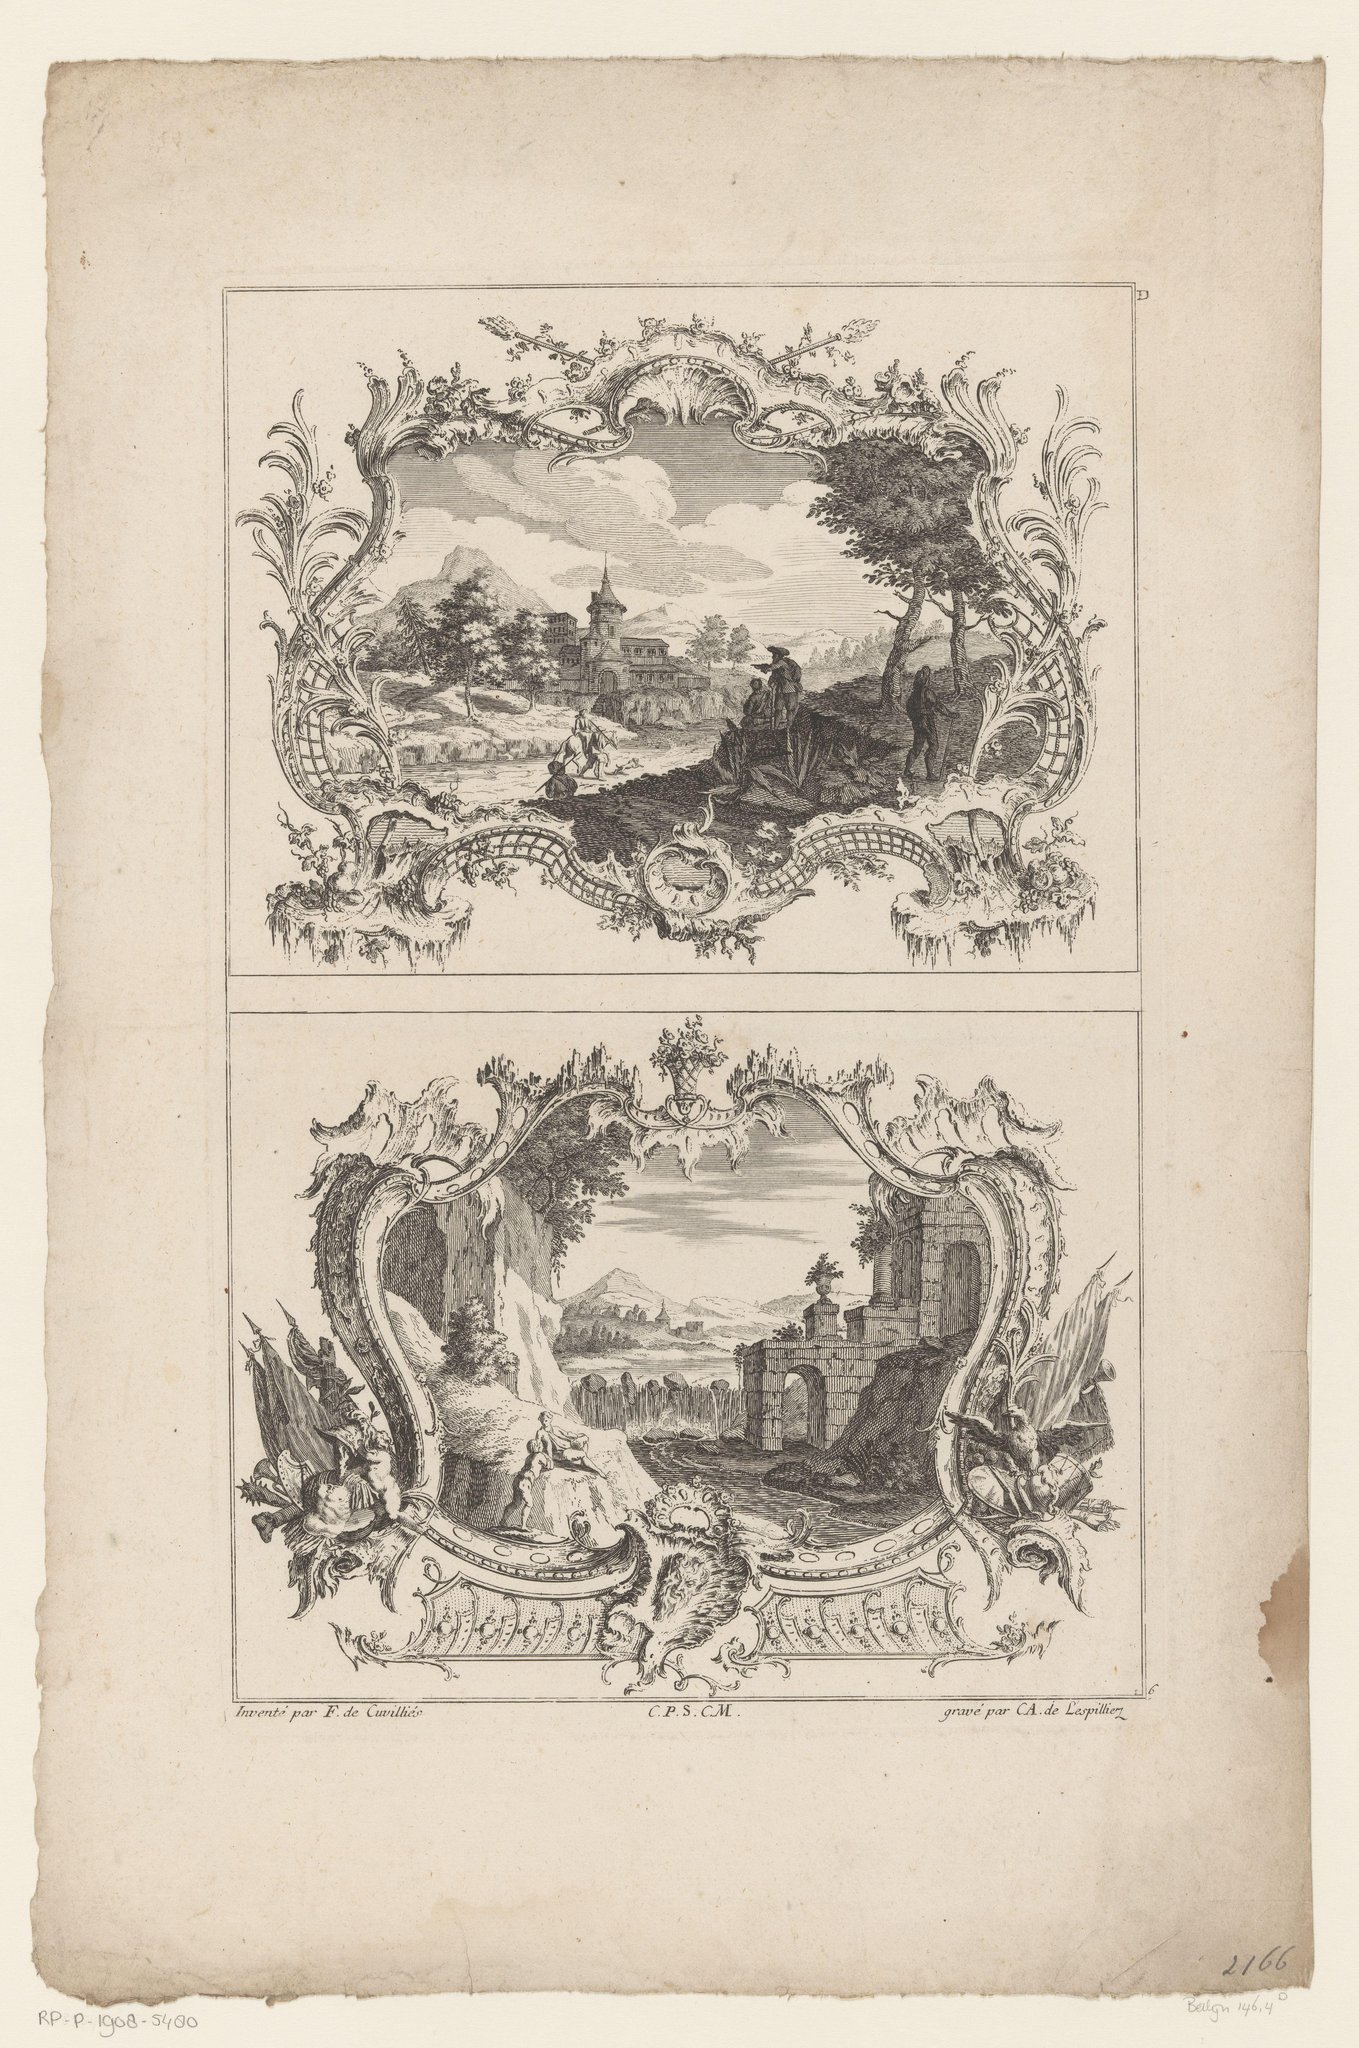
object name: print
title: 4 D Morceaux de Caprices à divers usages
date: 1745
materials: paper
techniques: etching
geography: germany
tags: river, city-view, and landscape with man-made constructions (+ city(-scape) with figures, staffage)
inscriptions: collector's mark: Lugt 2228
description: Twee landschappen in een omlijsting met thyrsi en vlaggen en wapens. Boven: Vier figuren op een heuvel, op de weg voor hen loopt een man met een vrouw op een paard richting een stad in de achtergrond. Onder: Twee figuren zitten op een oever van een rivier met rechts architectuur met rondbogen.